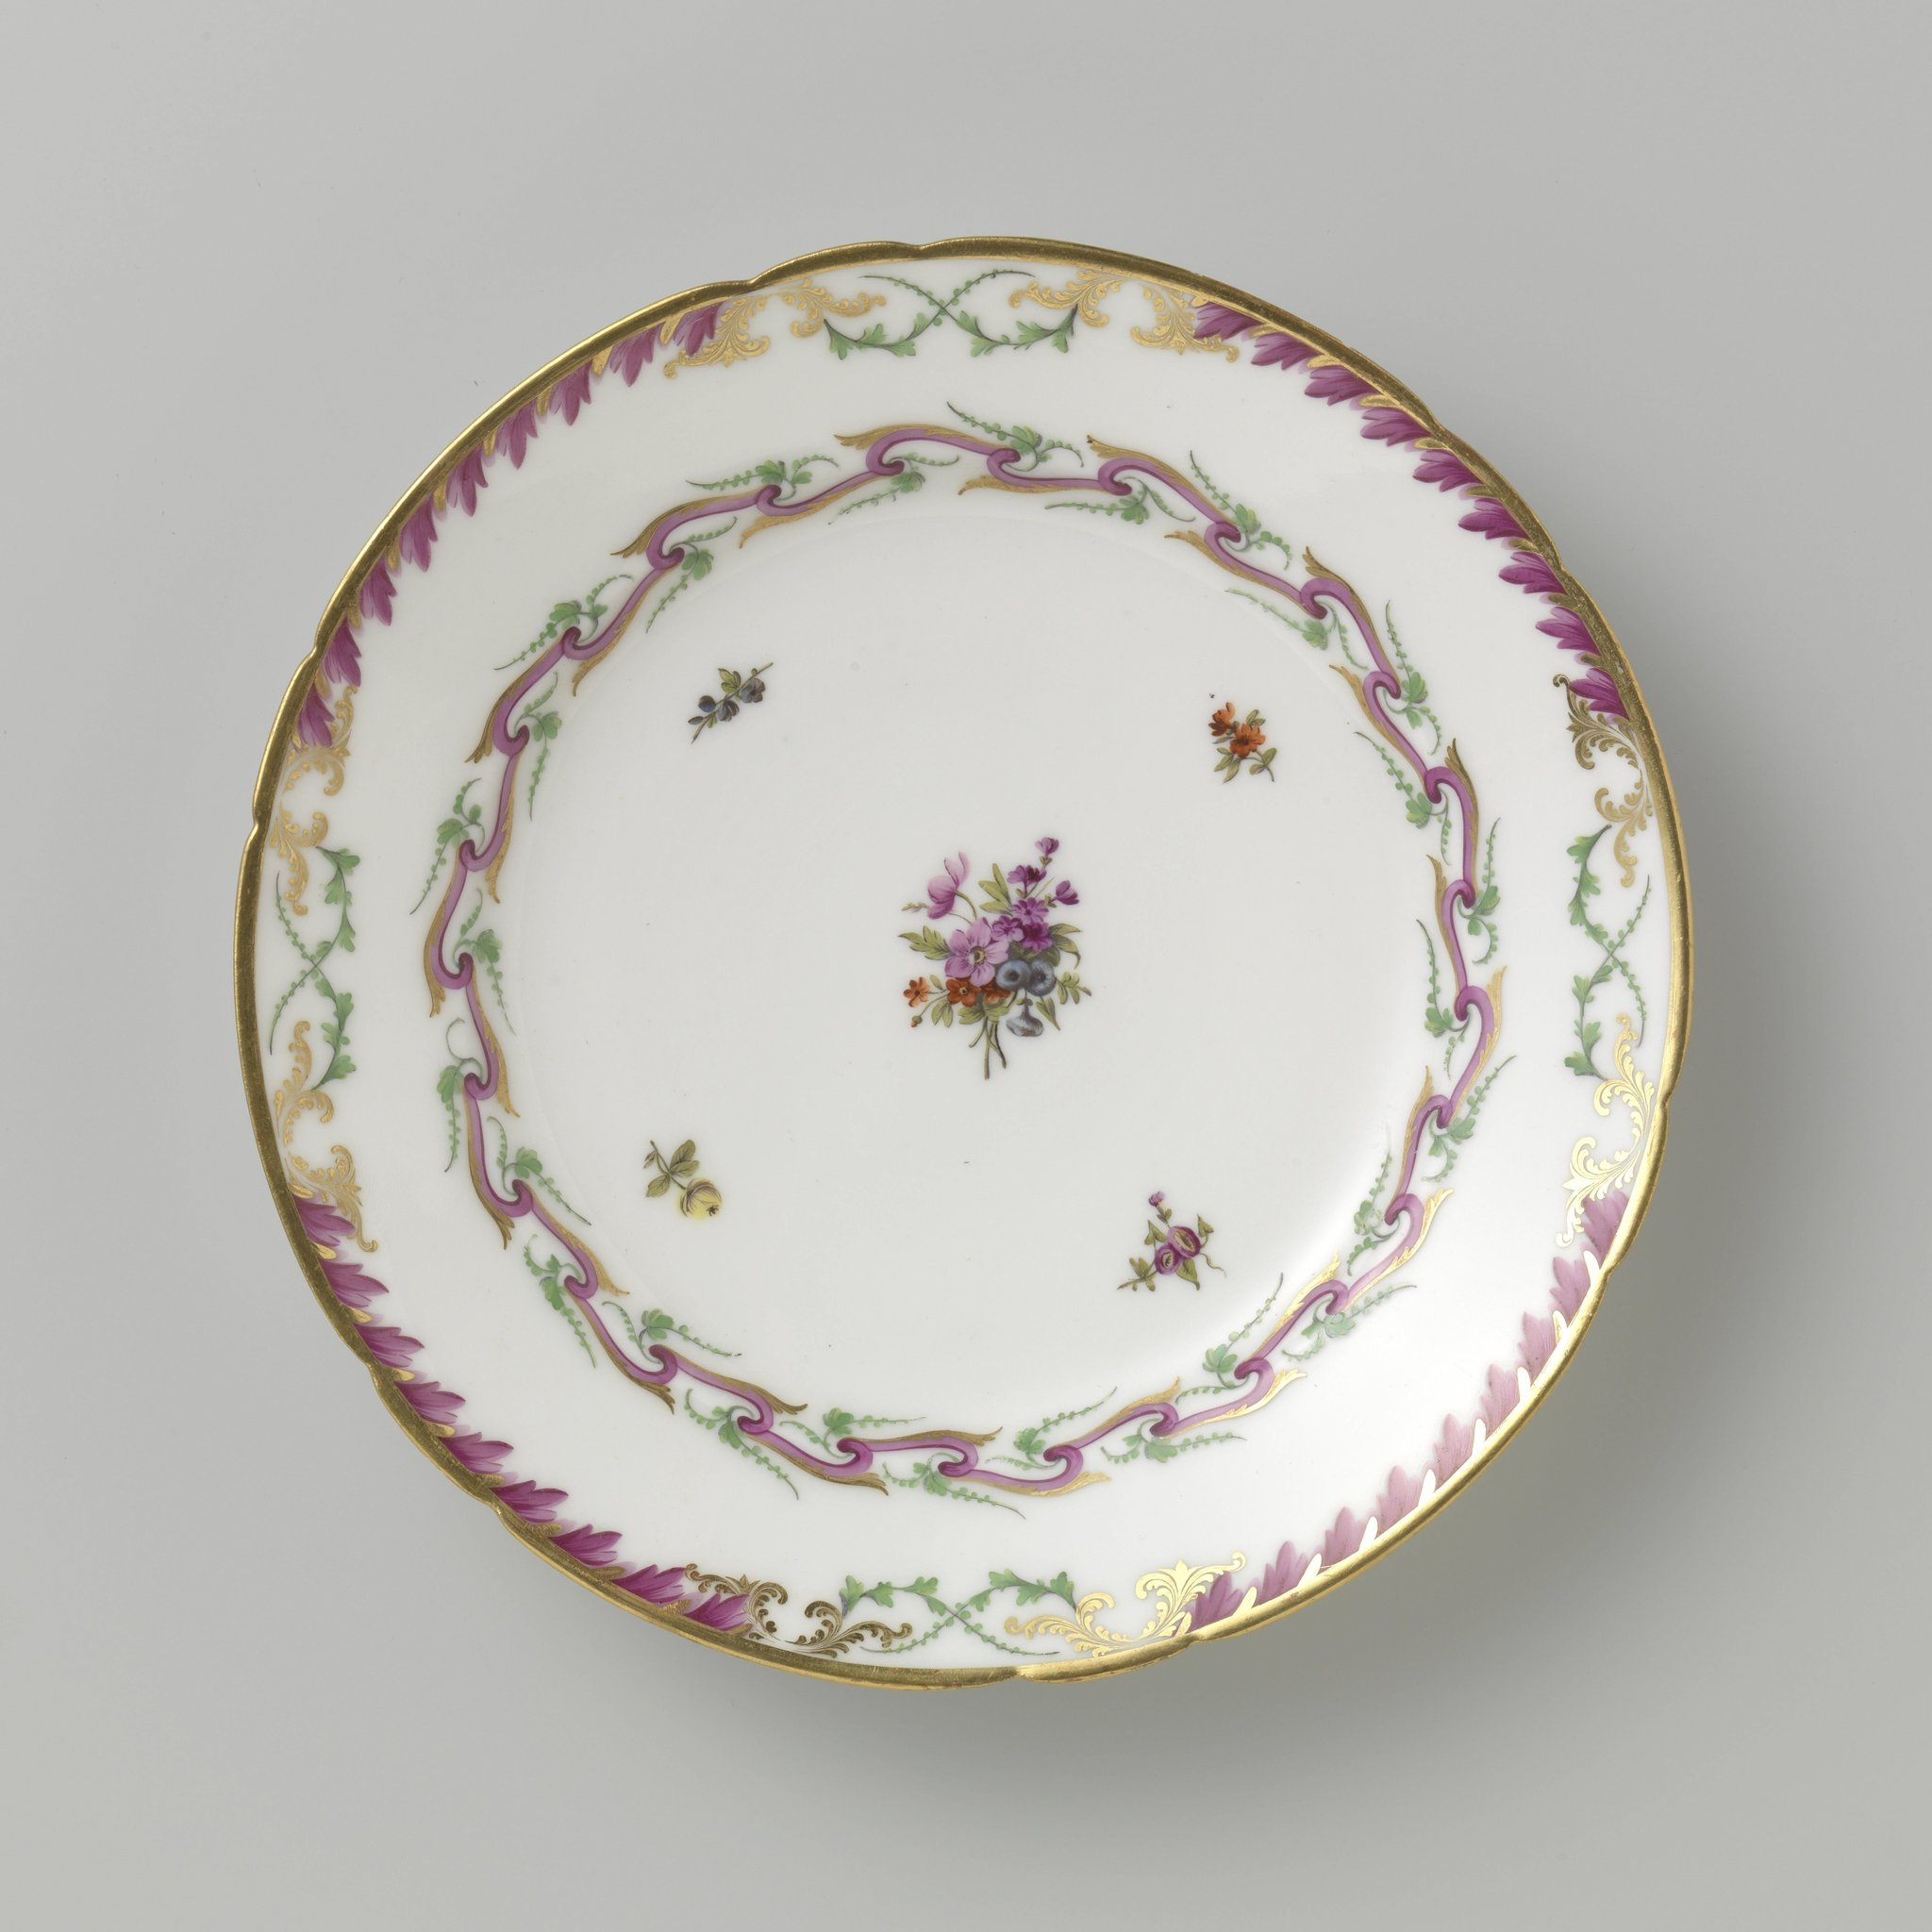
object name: plate dish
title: Bord, plat model, behorend bij een servies met geslingerd lintmotief met bladertakken, bloemboeketten en gestrooide bloemtakken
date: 1780-1820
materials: porcelain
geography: amsterdam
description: Bord, plat model, behorend bij een servies van porselein met geslingerd lintmotief in paars en goud met groene bladertakken, bloemboeketten en gestrooide bloemtakken. Randen lichtgegolfd met decoratie in goud met paars bladmotief waartussen groen gekruist bladmotief. Gemerkt: M.O.L. of AMSTEL.